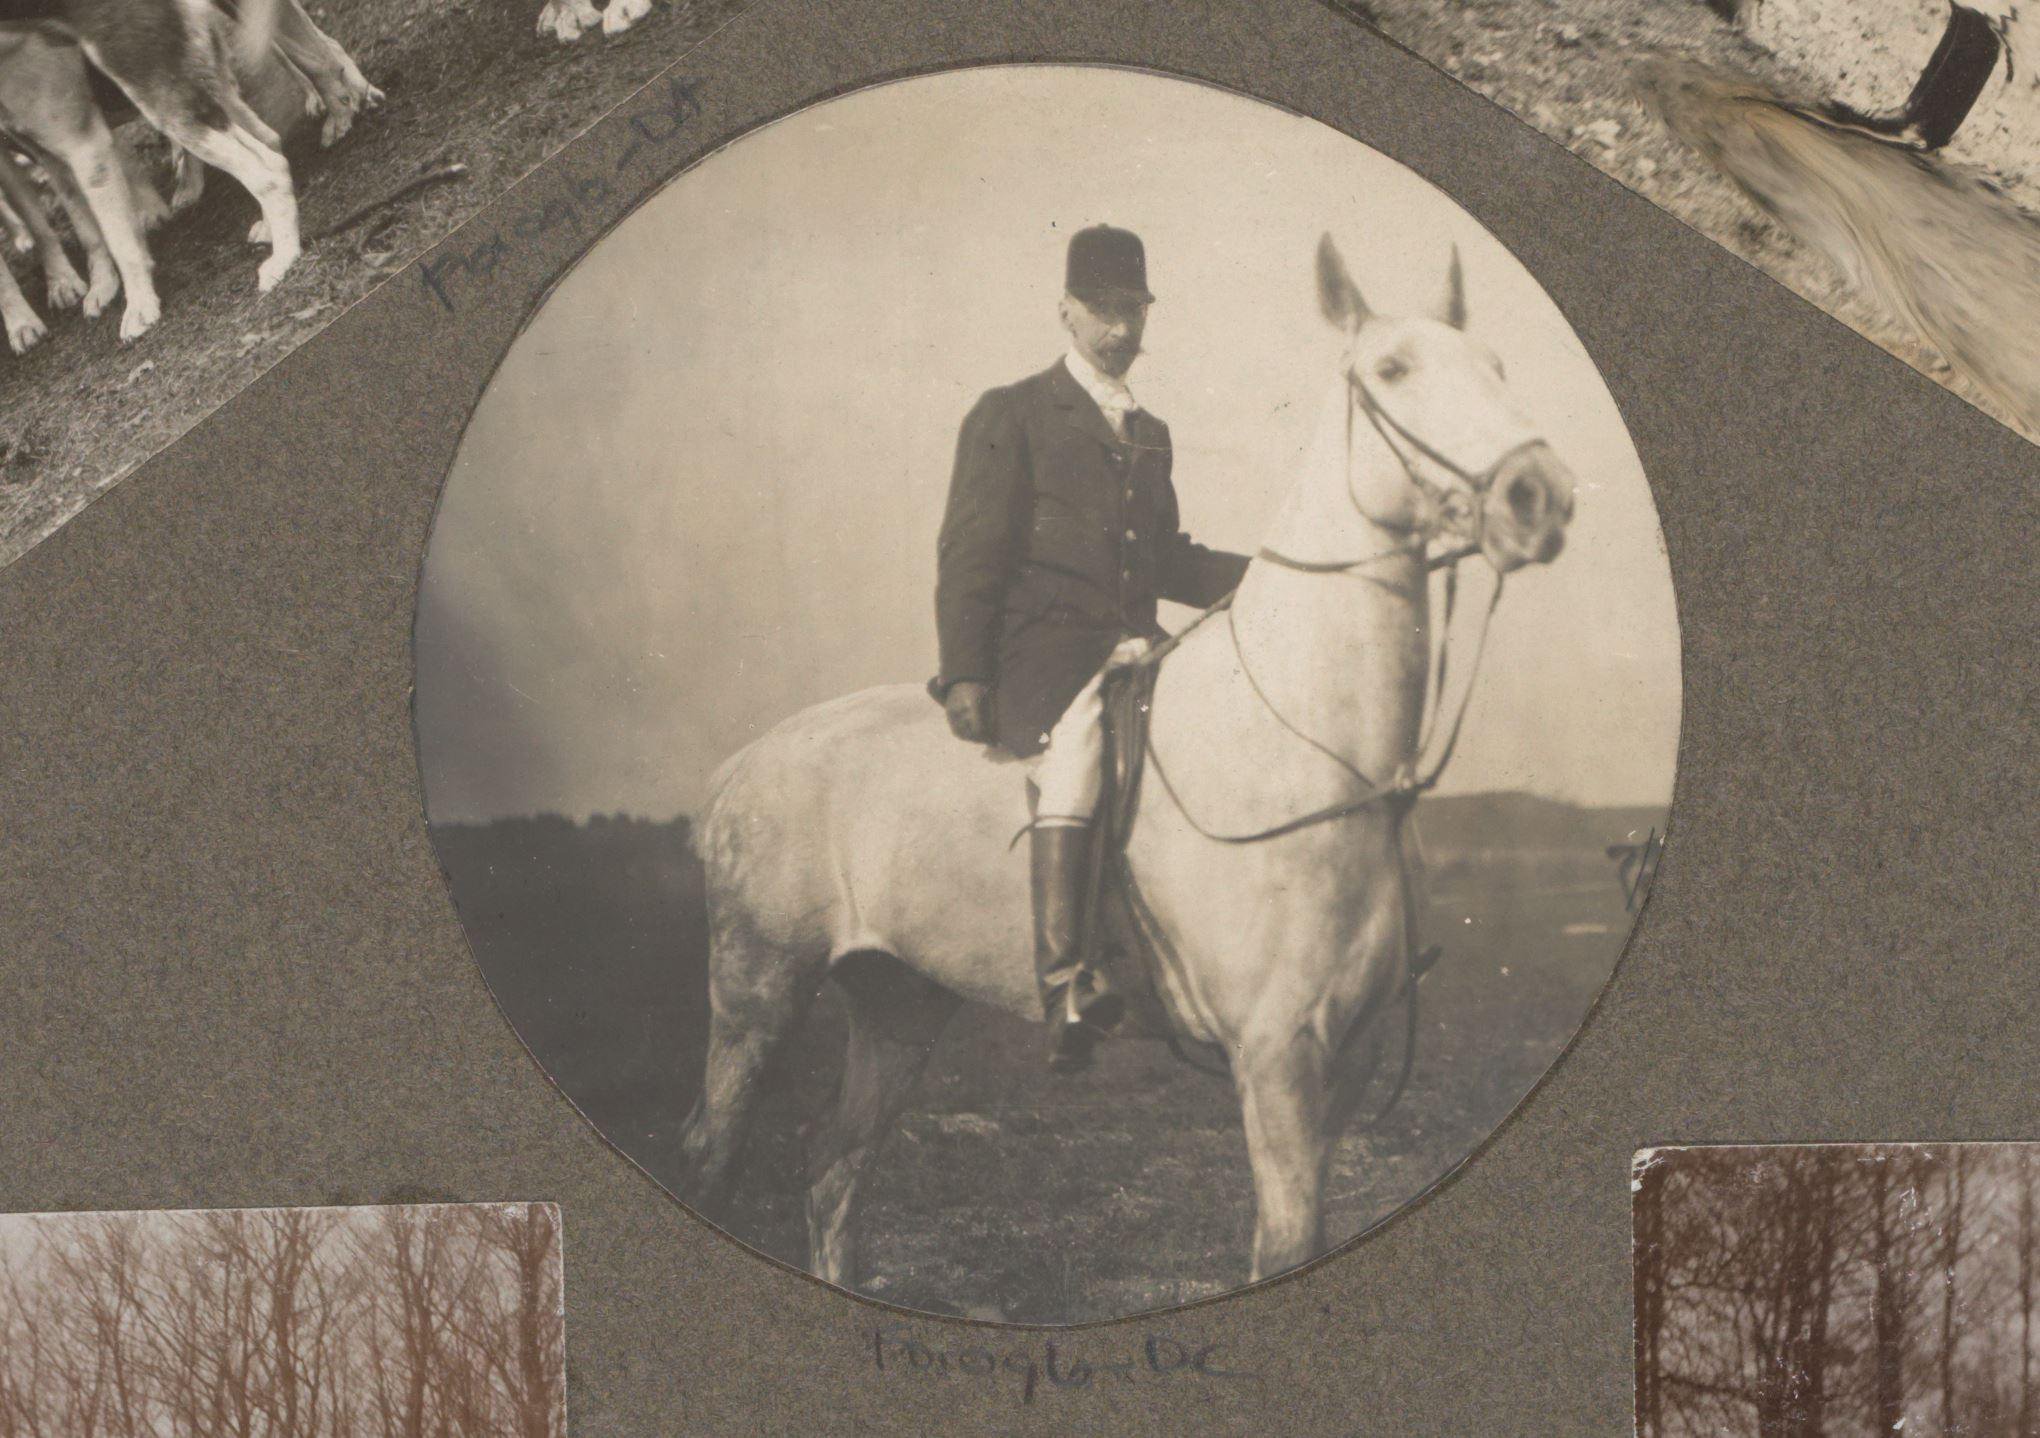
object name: album leaf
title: Ruitertafereel op Koninklijke Houtvesterij Het Loo: man te paard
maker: Anonymous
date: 1900-1925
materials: photographic support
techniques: gelatin silver print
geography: het loo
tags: riding a horse, ass, or mule; rider, horseman, hunting, chase, hunting-ground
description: Onderdeel van Fotoalbum van de heer Brams, opperhoutvester van koningin Wilhelmina op Koninklijke Houtvesterij Het Loo.